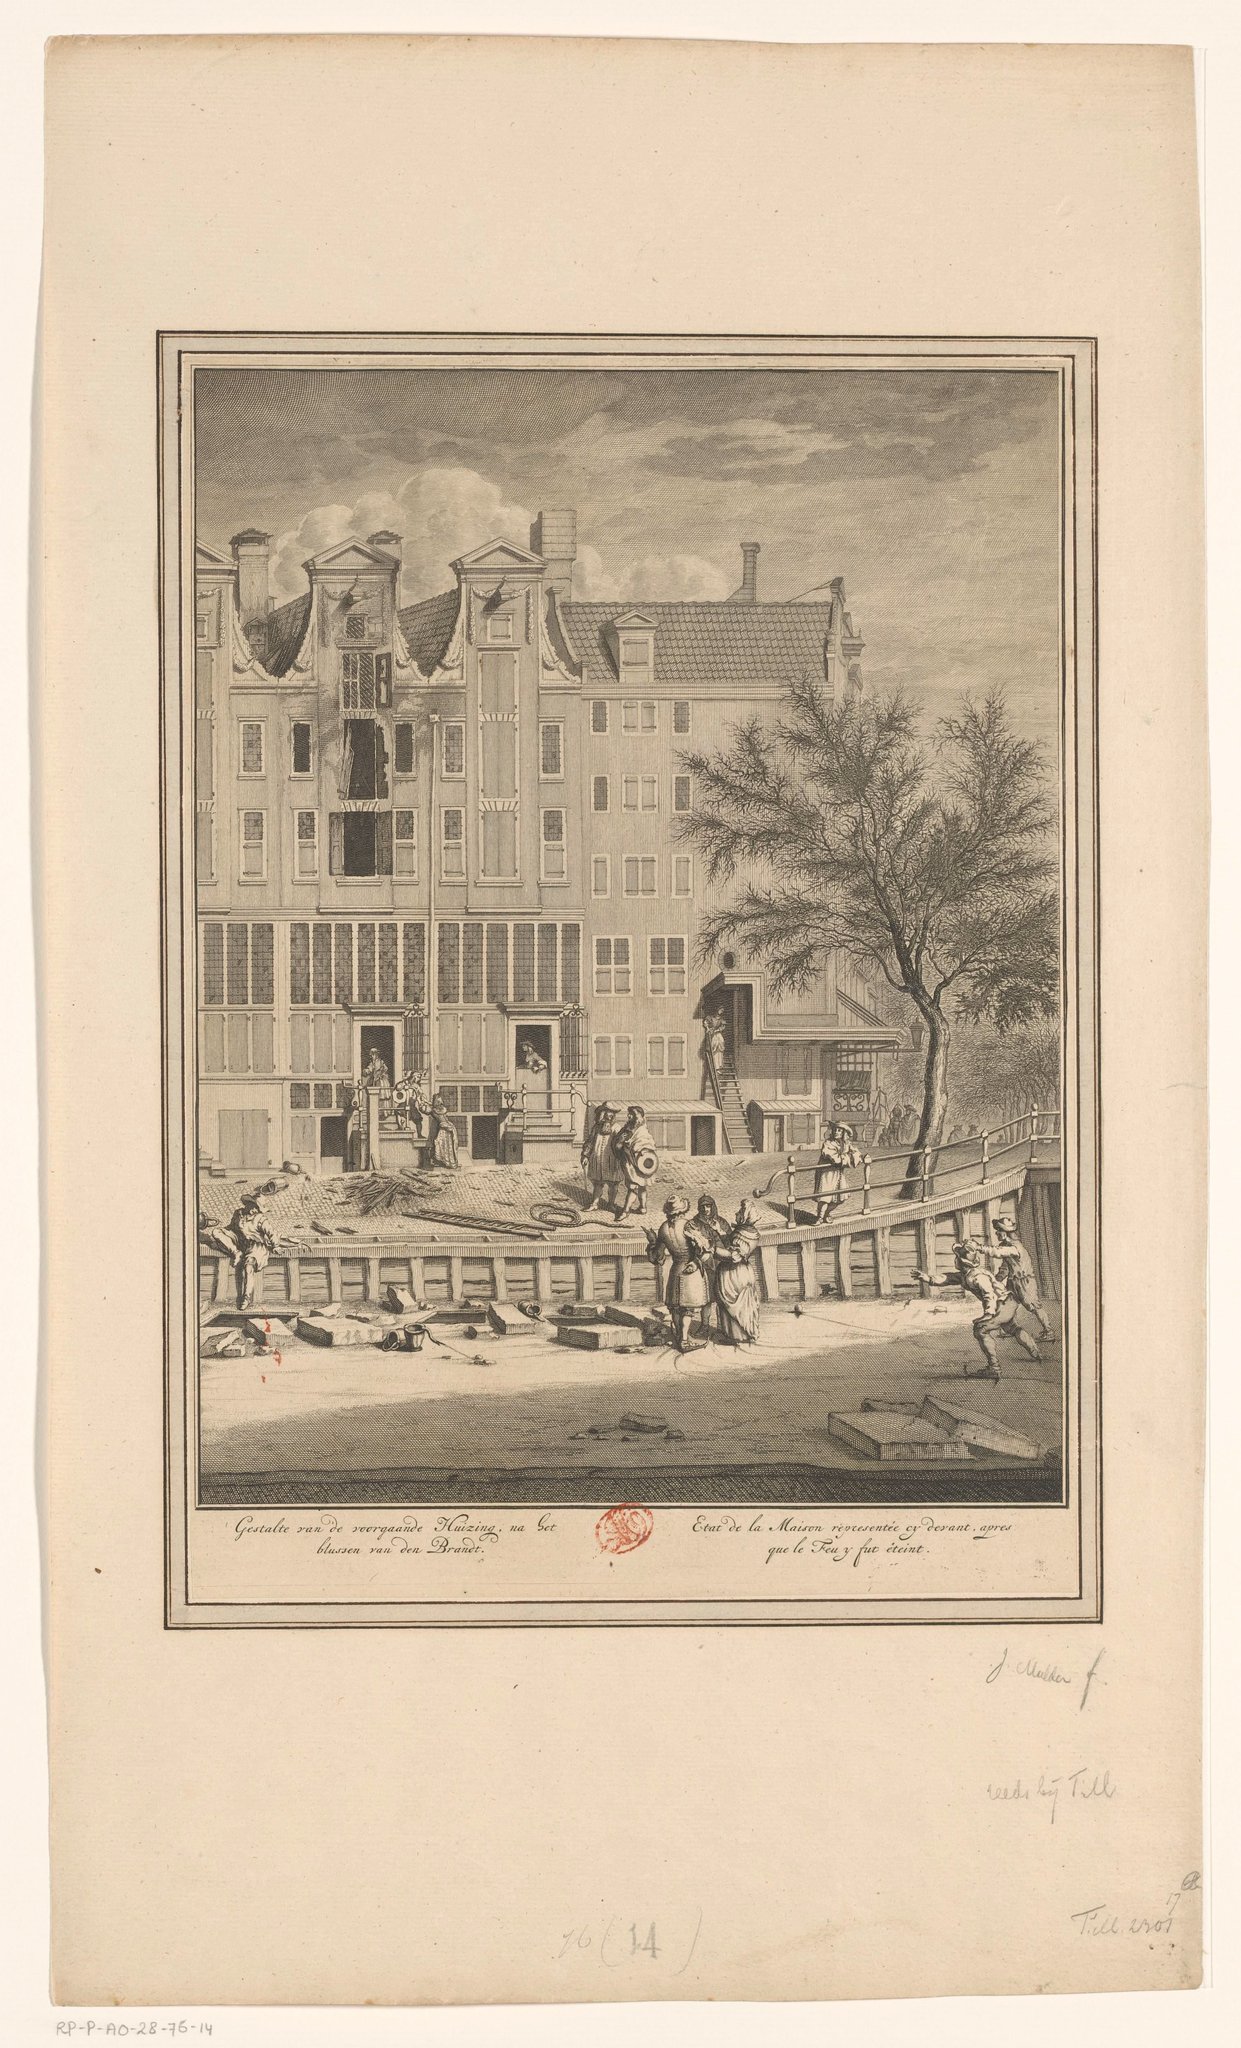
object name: book illustration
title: Gestalte van de voorgaande huizing, na het blussen van den brandt / Etat de la maison representée cy devant, apres que le feu y fut éteint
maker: joseph mulder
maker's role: print maker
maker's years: 1658-1718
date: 1690-1735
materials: paper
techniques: engraving, etching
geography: amsterdam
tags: painter, print maker, draughtsman, jan van der heyden, urban housing, ruin of a building ~ architecture, skates (winter sports), canals, waters (in city), fire-fighting, fire-extinguishing equipment, severe winters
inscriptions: collector's mark: Lugt 2228, collector's mark: Lugt 195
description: Prent ook gebruikt in: Heyden, Jan van der. Beschryving der nieuwlyks uitgevonden en geoctrojeerde slang-brand-spuiten en haare wyze van brand-blussen, tegenwoordig binnen Amsterdam in gebruik zijnde (…). 1e druk. Amsterdam: Jan Rieuwertsz. (II), 1690. En in: Heyden, Jan van der. Beschryving der nieuwlyks uitgevonden en geoctrojeerde slang-brand-spuiten en haare wyze van brand-blussen, tegenwoordig binnen Amsterdam in gebruik zijnde (…). 2e druk. Amsterdam: erfgenamen Jan van der Heyden, 1735. Voor ontwerptekeningen zie RP-T-1899-A-4210 en RP-T-00-159. Voor eerste bekende staat zie RP-P-OB-2365. Voor tweede bekende staat zie RP-P-OB-82.098. Voor tegendruk zie RP-P-OB-82.097.